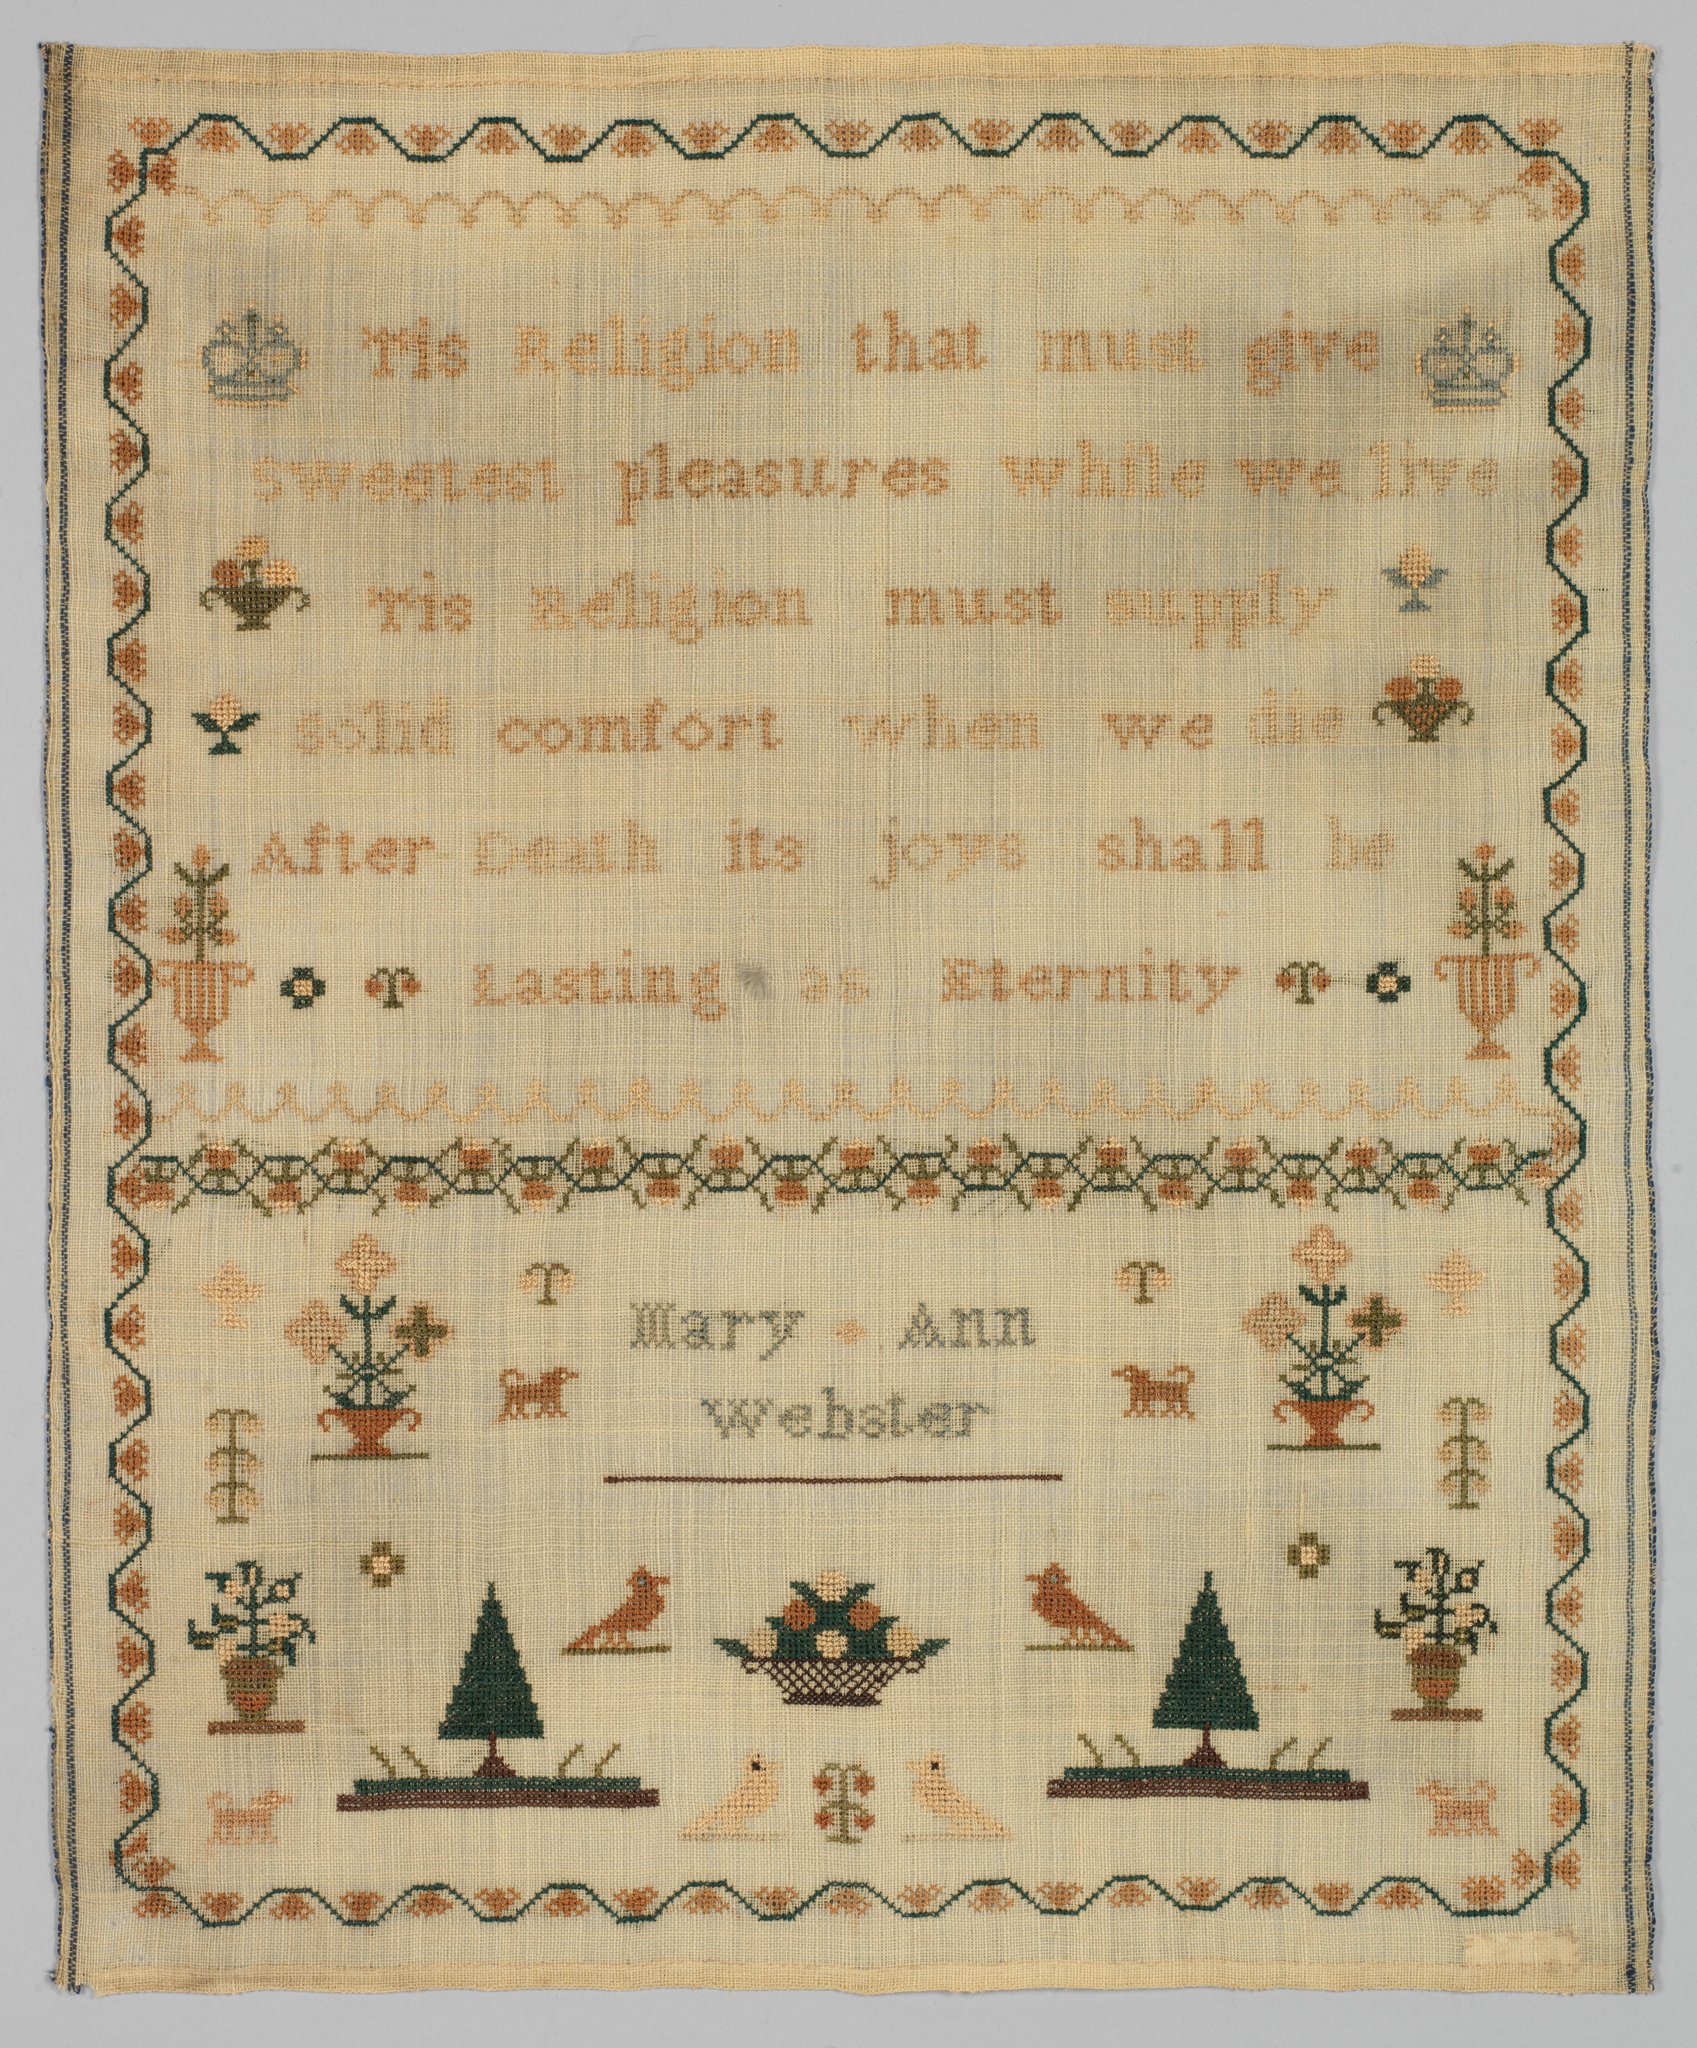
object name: sampler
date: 1801-1900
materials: wool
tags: birds,flowers,trees